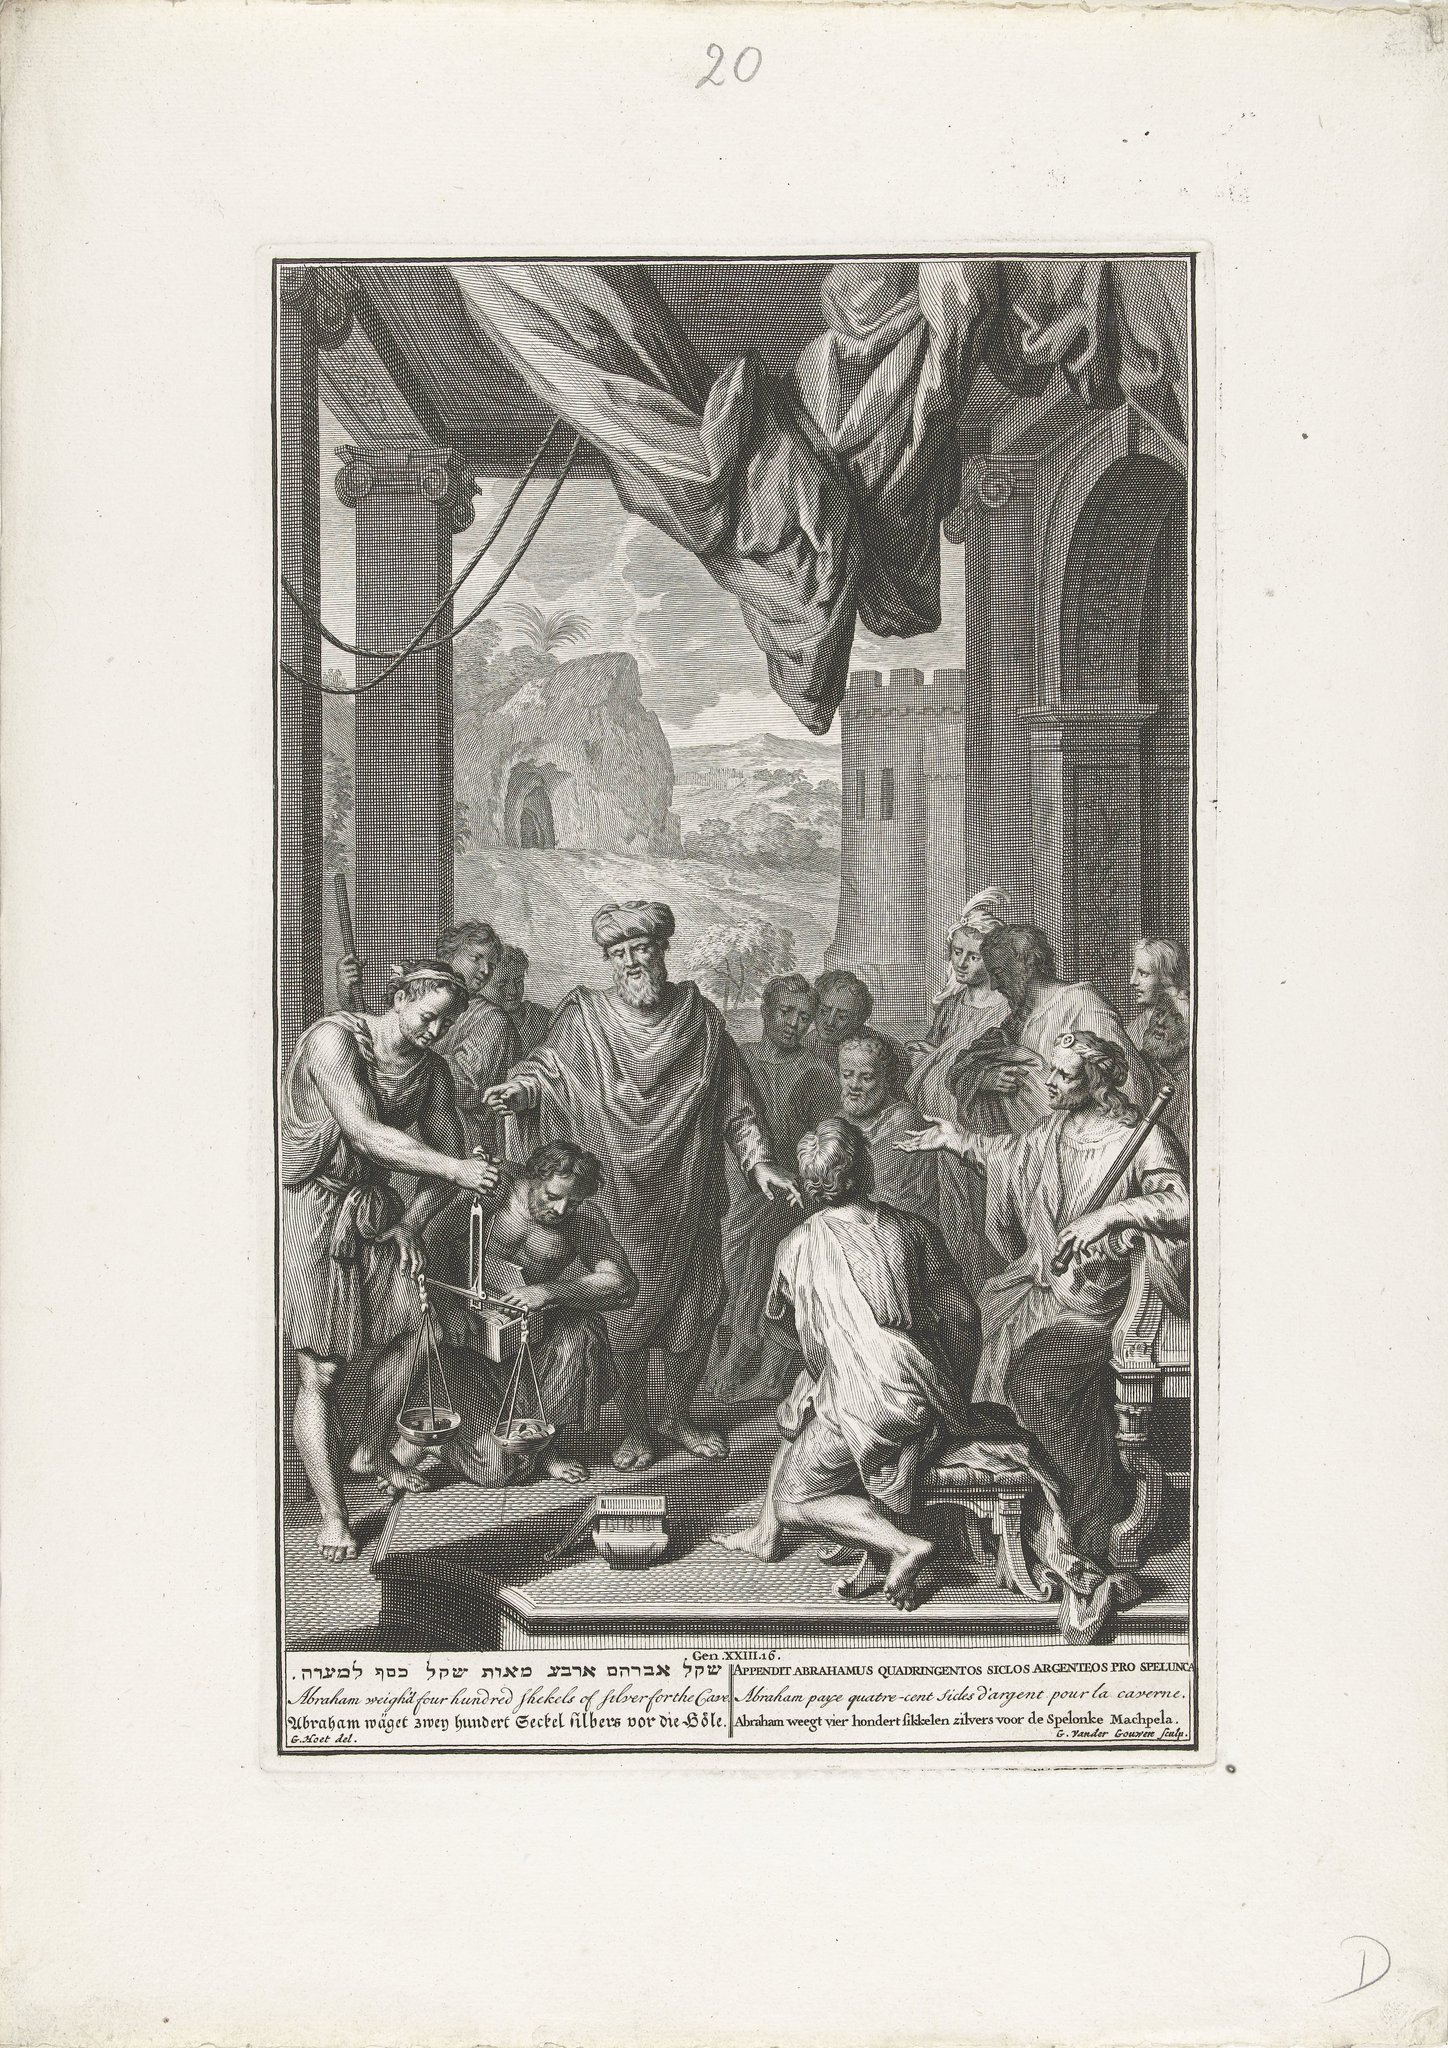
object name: print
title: Abraham koopt de akker van Efron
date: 1728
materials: paper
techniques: engraving, etching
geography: the hague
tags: abraham weighs out four hundred pieces of silver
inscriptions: collector's mark: Lugt 2228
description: Abraham koopt de akker van Efron voor vierhonderd sjekel zilver (Gen. 23:16). Abraham weegt het zilver af. Op de achtergrond de grot waarin Abraham zijn vrouw wilt begraven. De prent heeft een Hebreeuws, Latijns, Frans, Engels, Duits en Nederlands onderschrift.